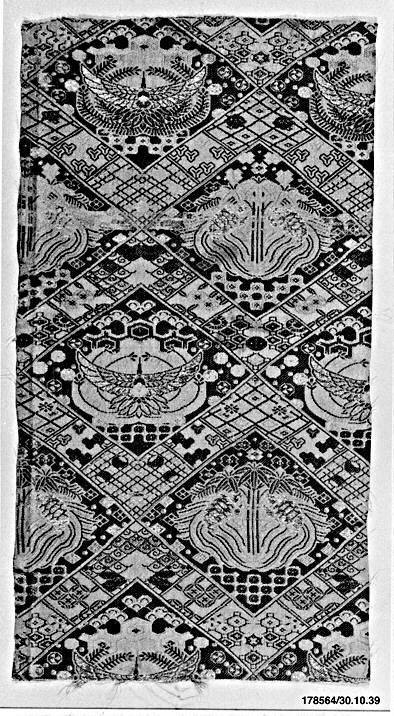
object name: piece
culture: japanese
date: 1801-1900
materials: metal thread, silk